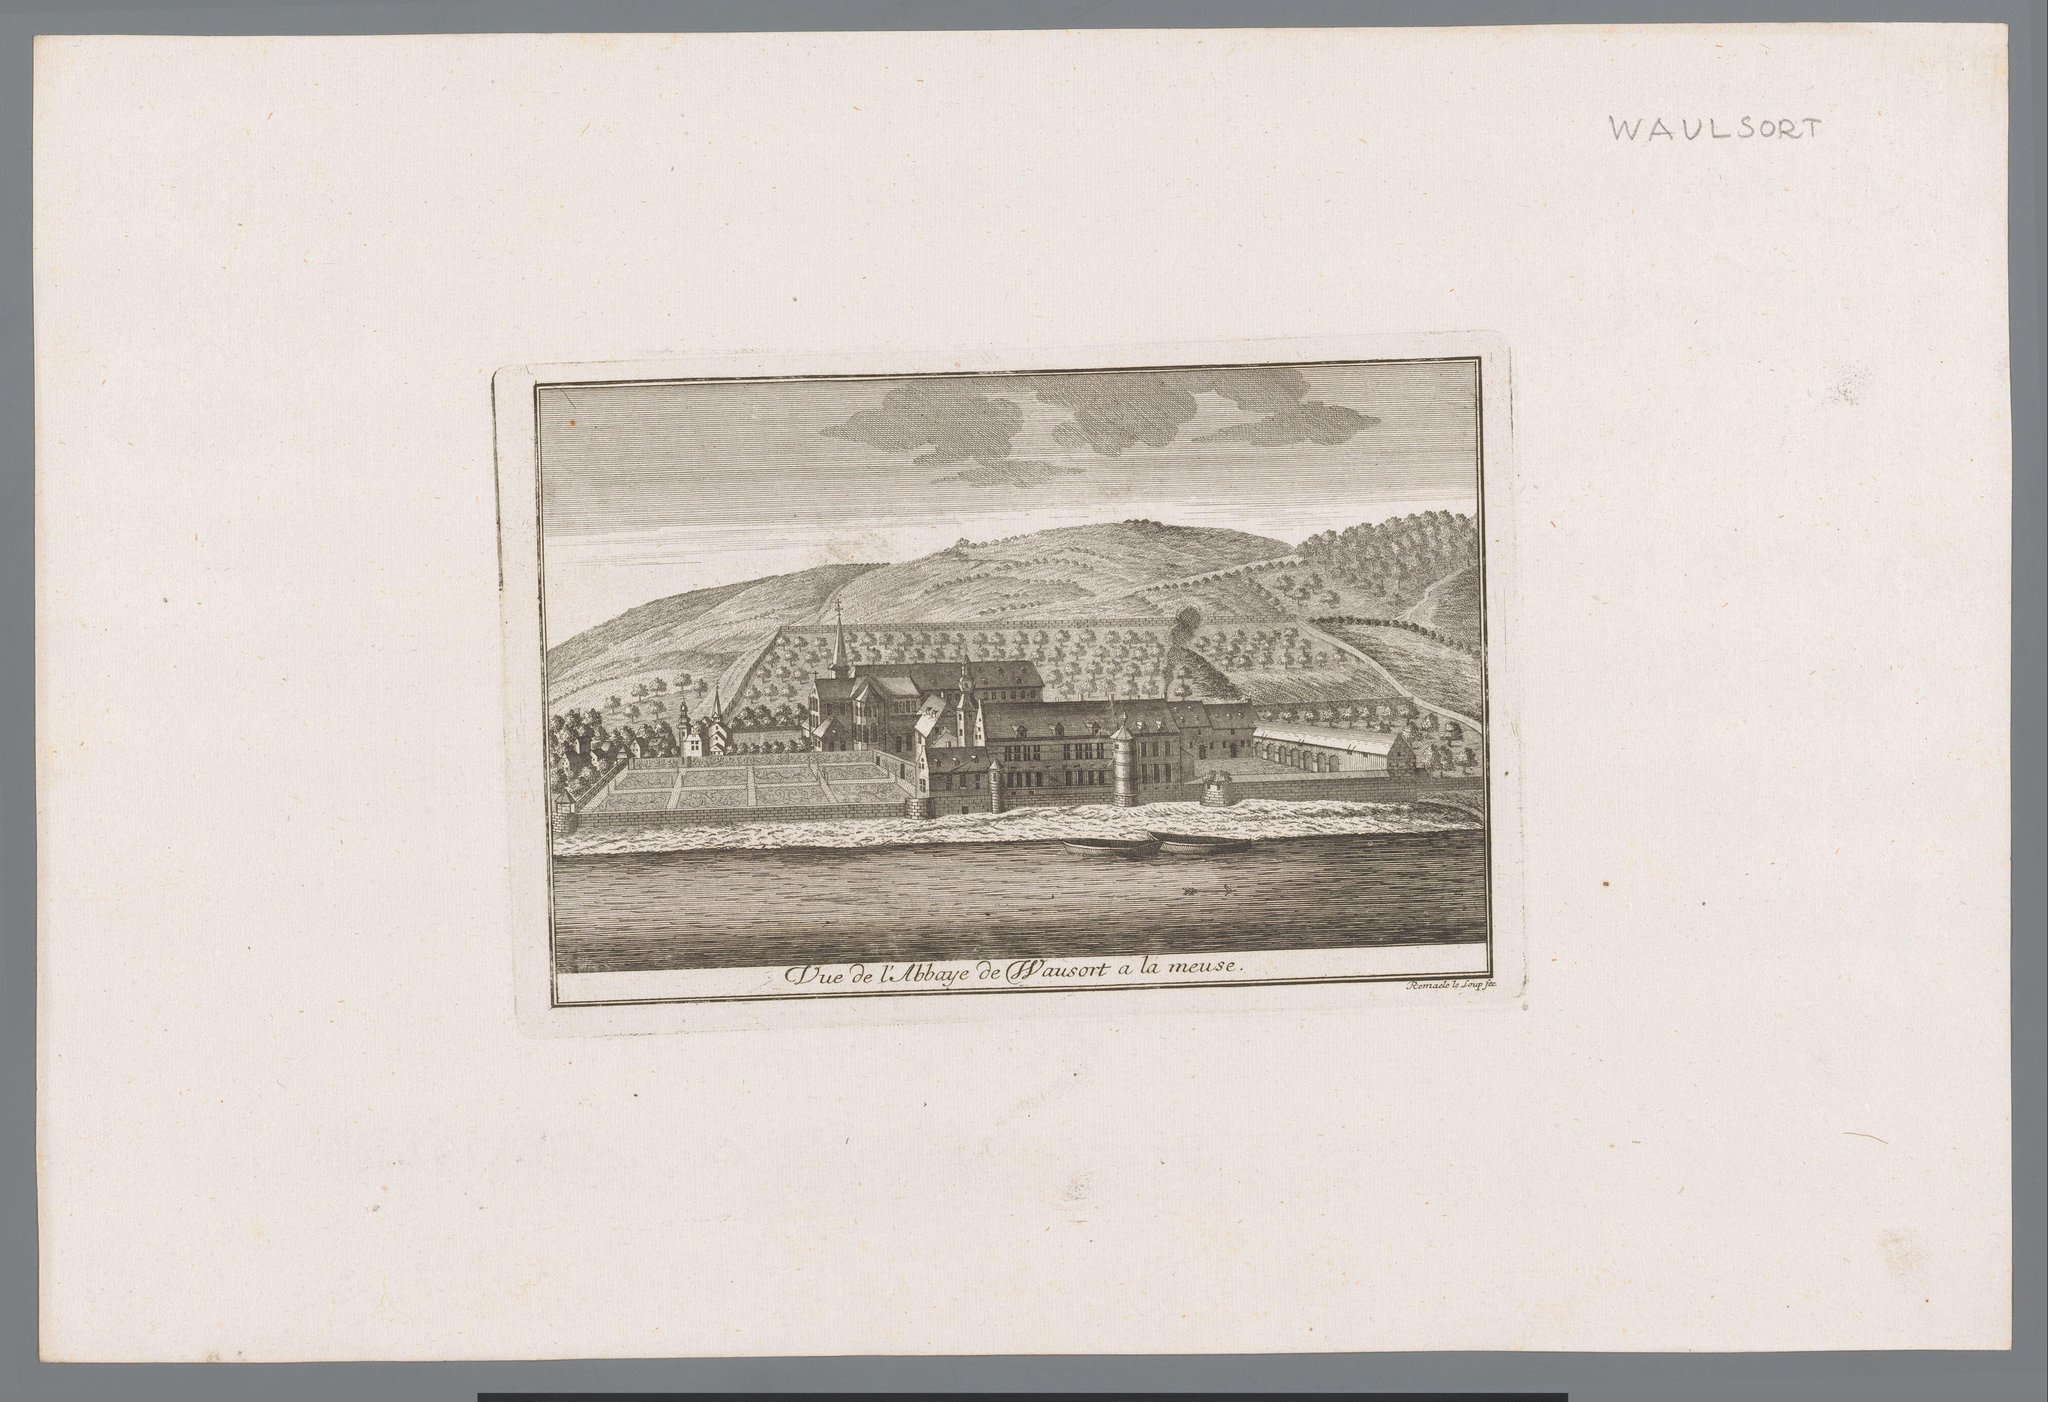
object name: print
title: Vue de l'abbaye de Wausort a la Meuse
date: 1738-1744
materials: paper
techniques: engraving, etching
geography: liège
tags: abbey, monastery, convent ~ roman catholic church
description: Prent uit: Johanne de Saumery, Alexandre de et al. Les délices du païs de Liège, ou description géographique, topographique et chorographique des monumes sacrés et profanes (...). 5 dln. Luik: Everard Kints, 1738-1744, dl. 2, p. 277.